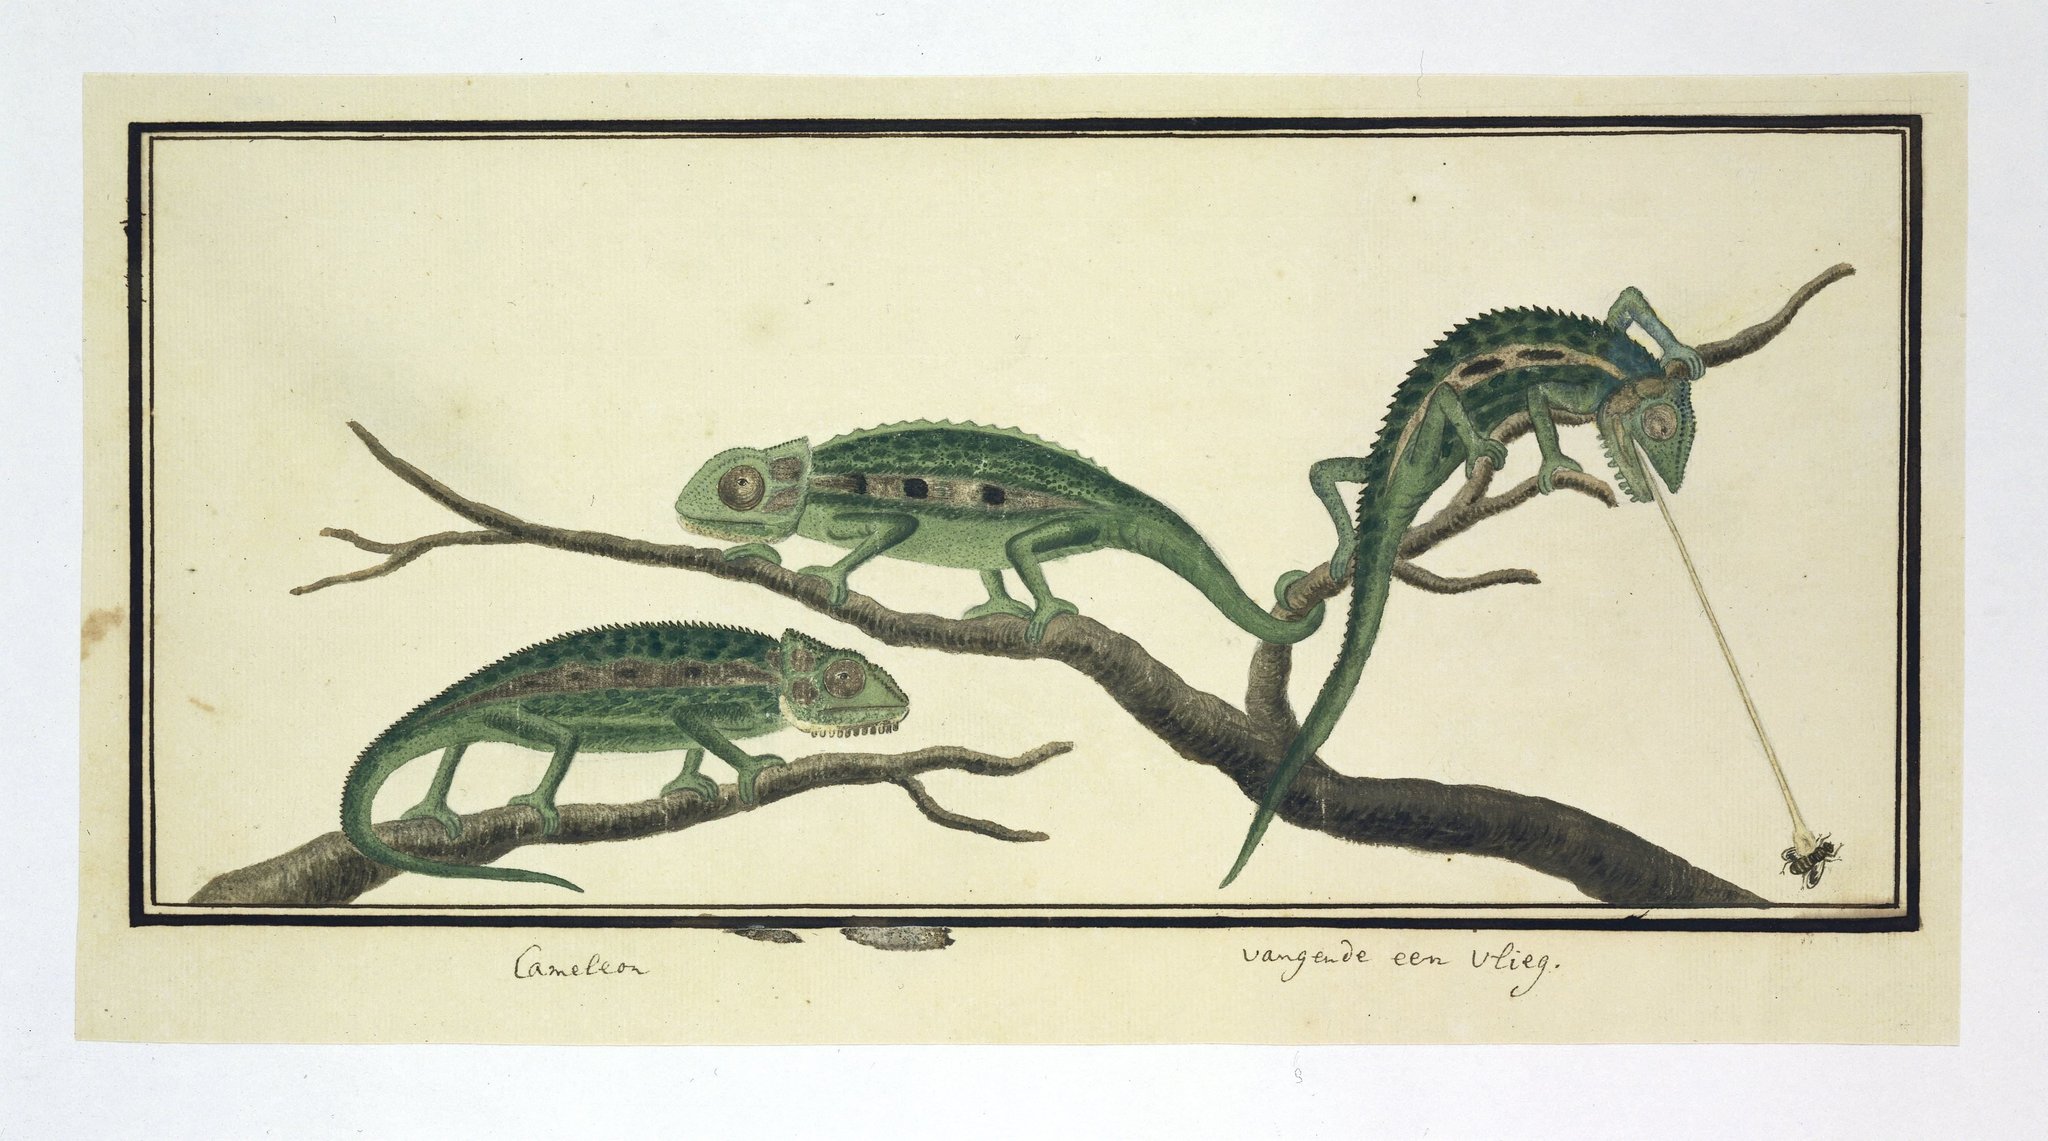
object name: drawing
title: Bradypodion pumilum in three poses (Cape dwarf chameleon)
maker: robert jacob gordon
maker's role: draughtsman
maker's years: 1743-1795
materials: chalk, ink, paper, pencil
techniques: brush, pen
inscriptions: annotation: ‘Cameleon (links) vangende een vlieg. (rechts)’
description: Drie dwergkameleons (Bradypodion pumilum), waarvan er een net een vlieg op zijn uitgerolde tong heeft gevangen.